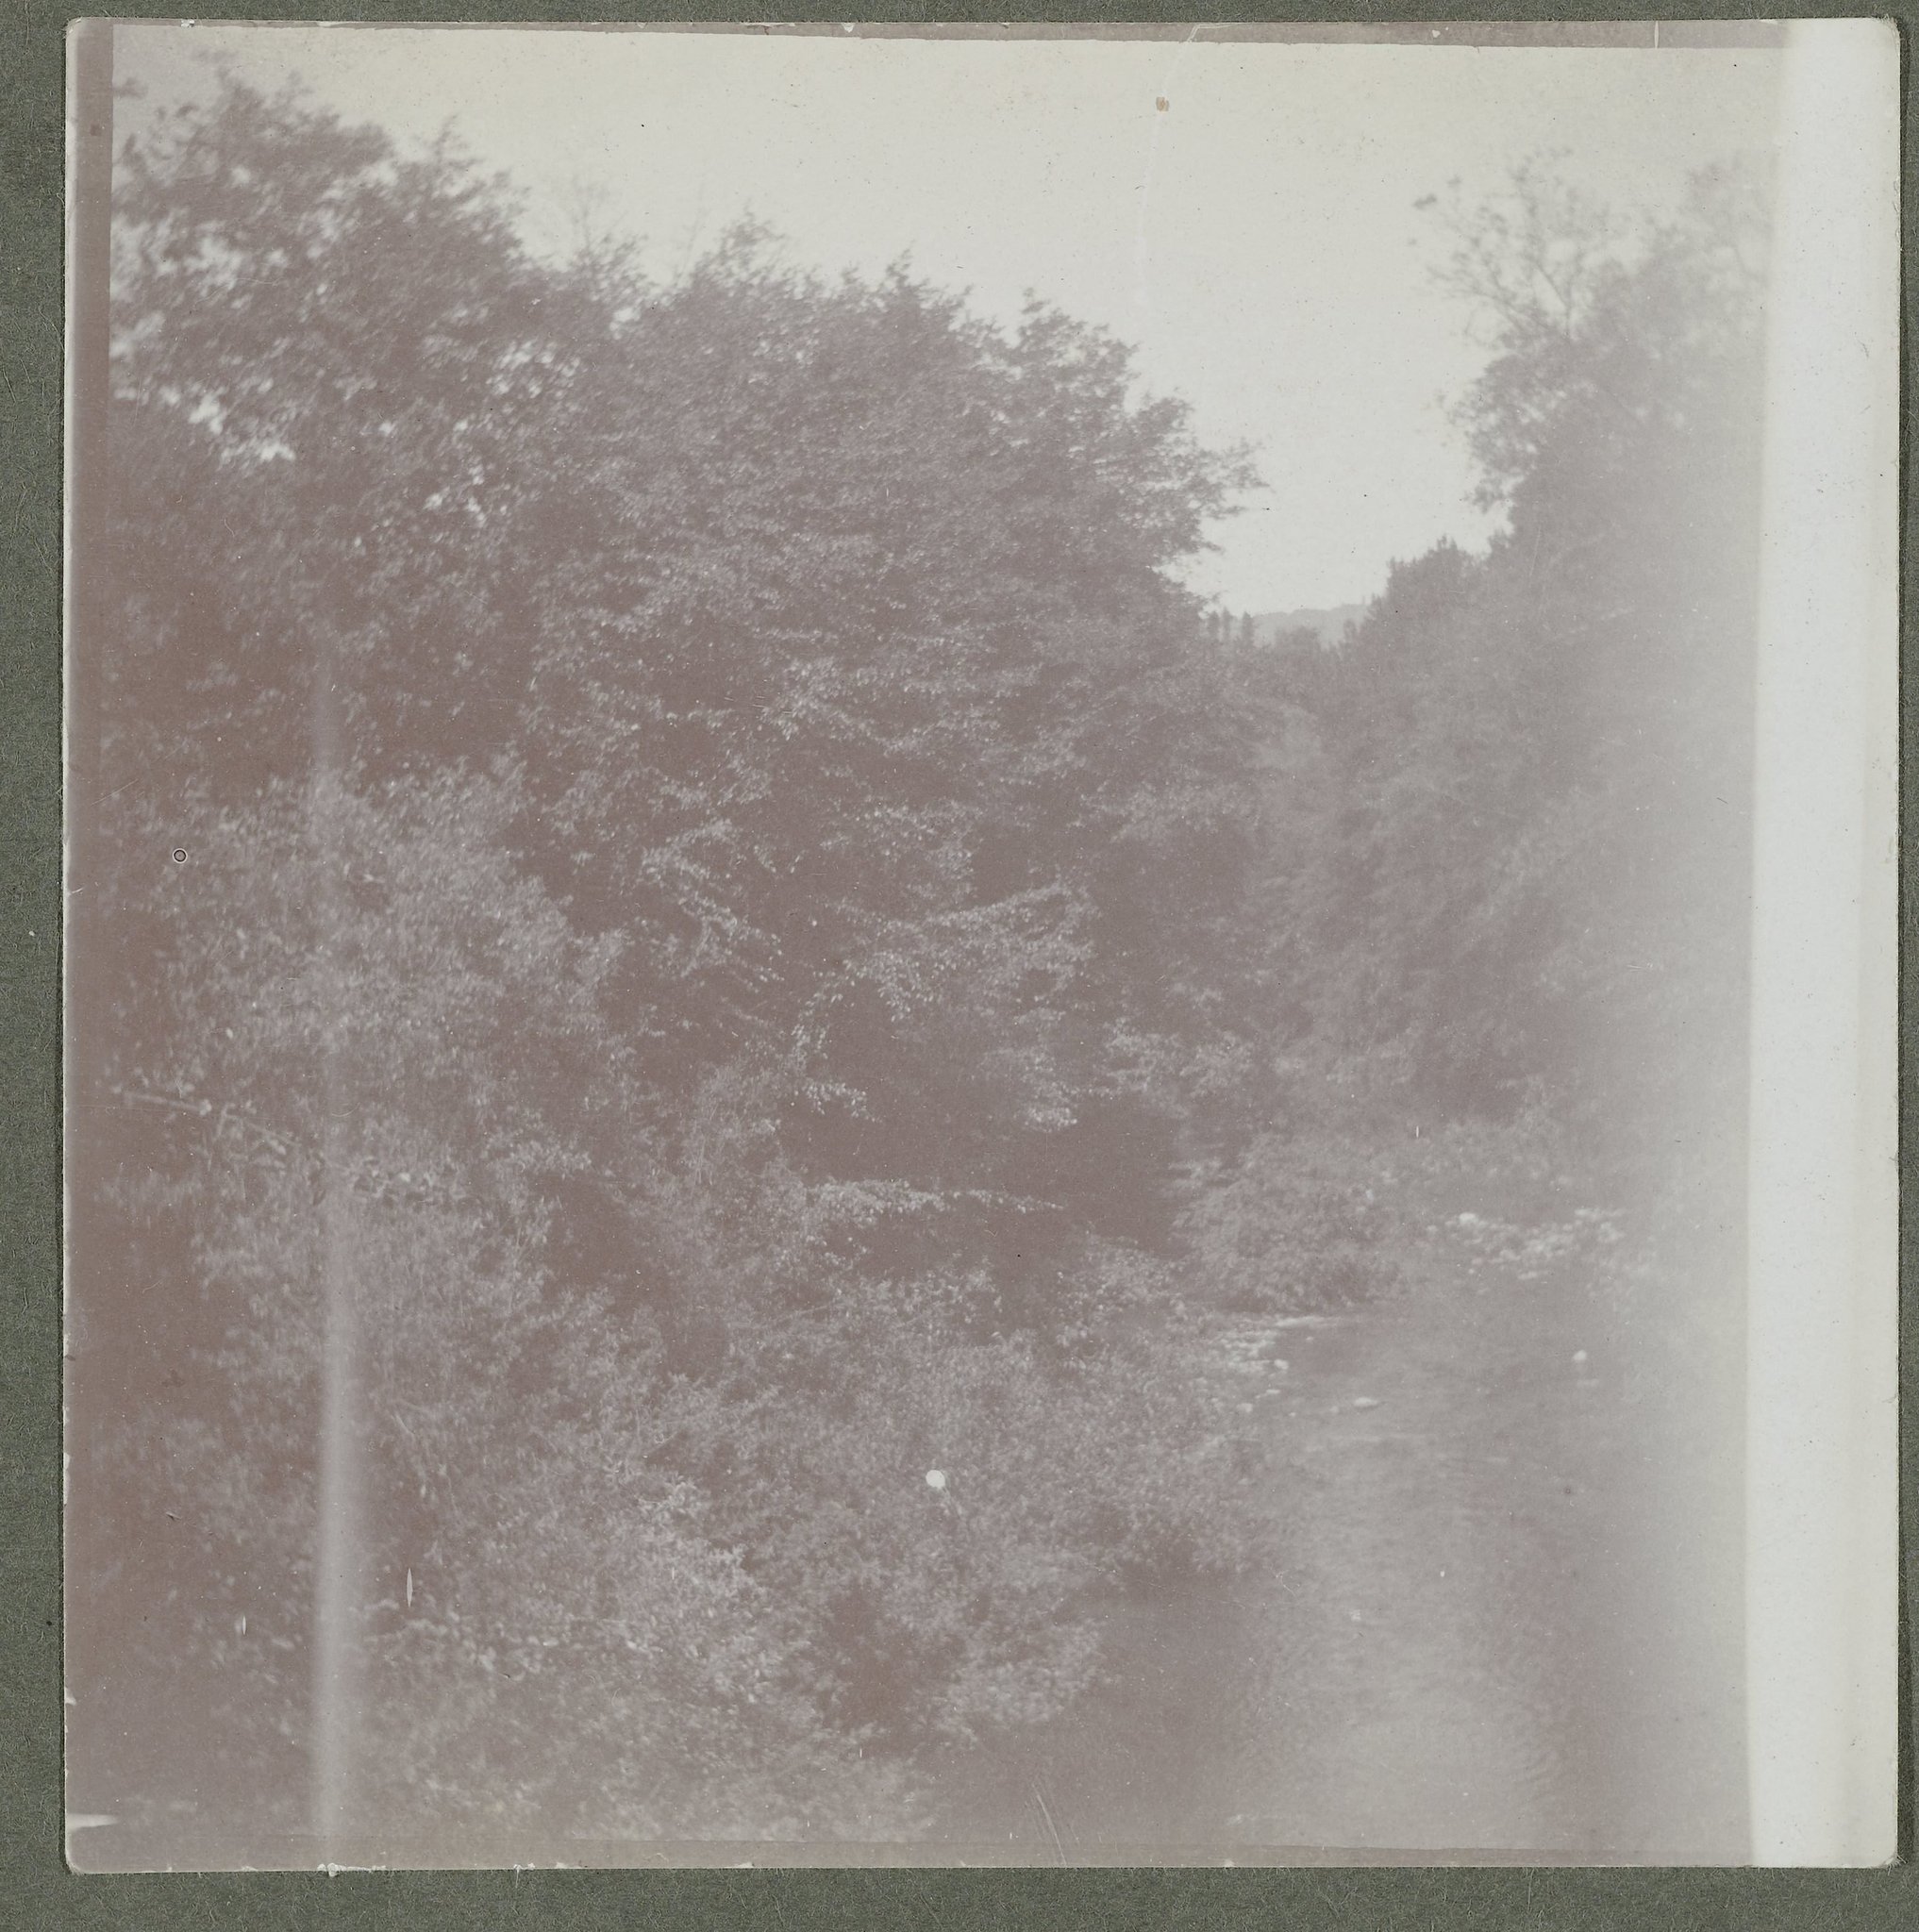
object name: photograph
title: Gebouw van Pleasant Island Camp aan Cupsuptic Lake, Maine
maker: Anonymous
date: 1900-1920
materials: paper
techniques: gelatin silver print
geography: maine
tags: cottage